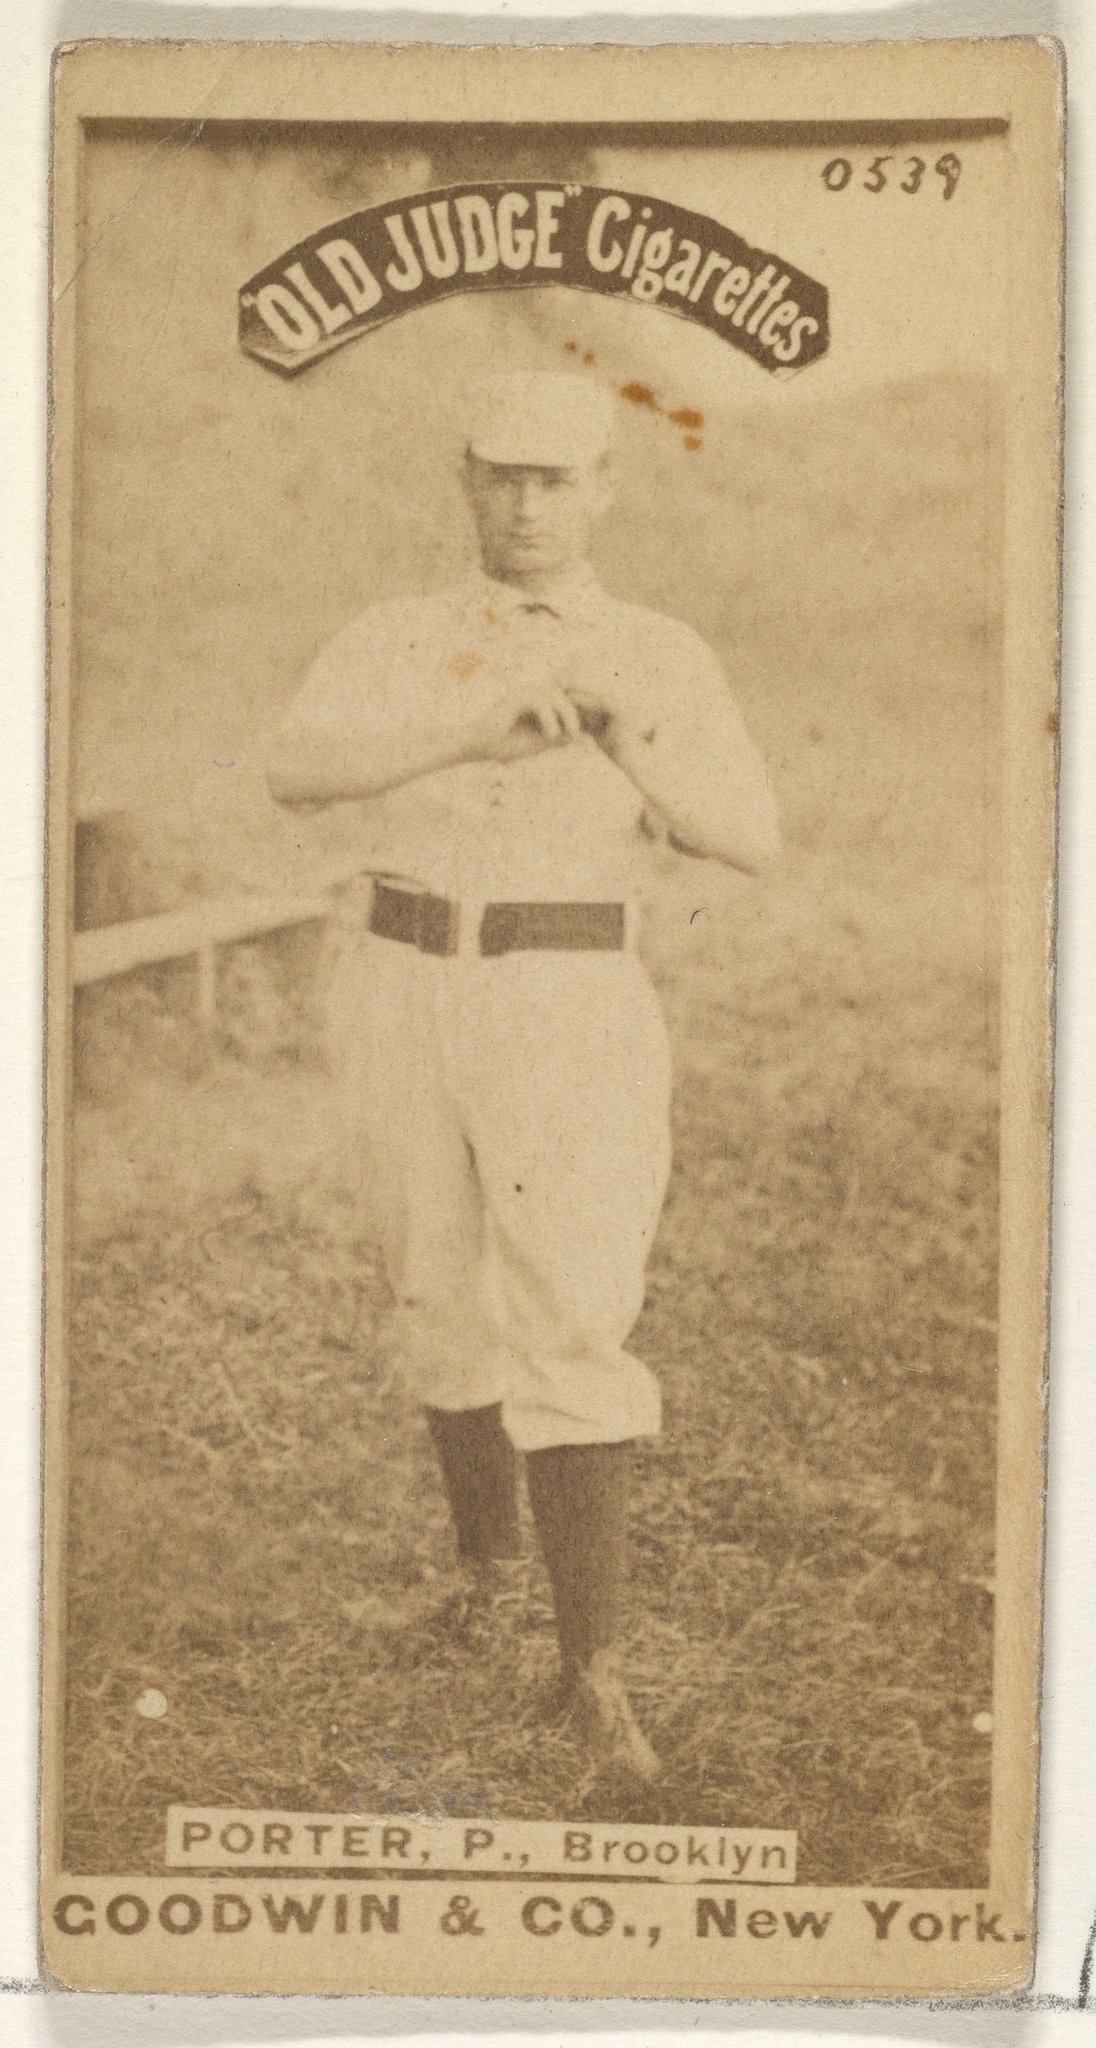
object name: baseball card, photograph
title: Porter, Pitcher, Brooklyn, from the Old Judge series (N172) for Old Judge Cigarettes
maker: goodwin & company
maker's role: publisher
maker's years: 1850-1950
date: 1887-1890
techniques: albumen silver print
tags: men,portraits,baseball,athletes